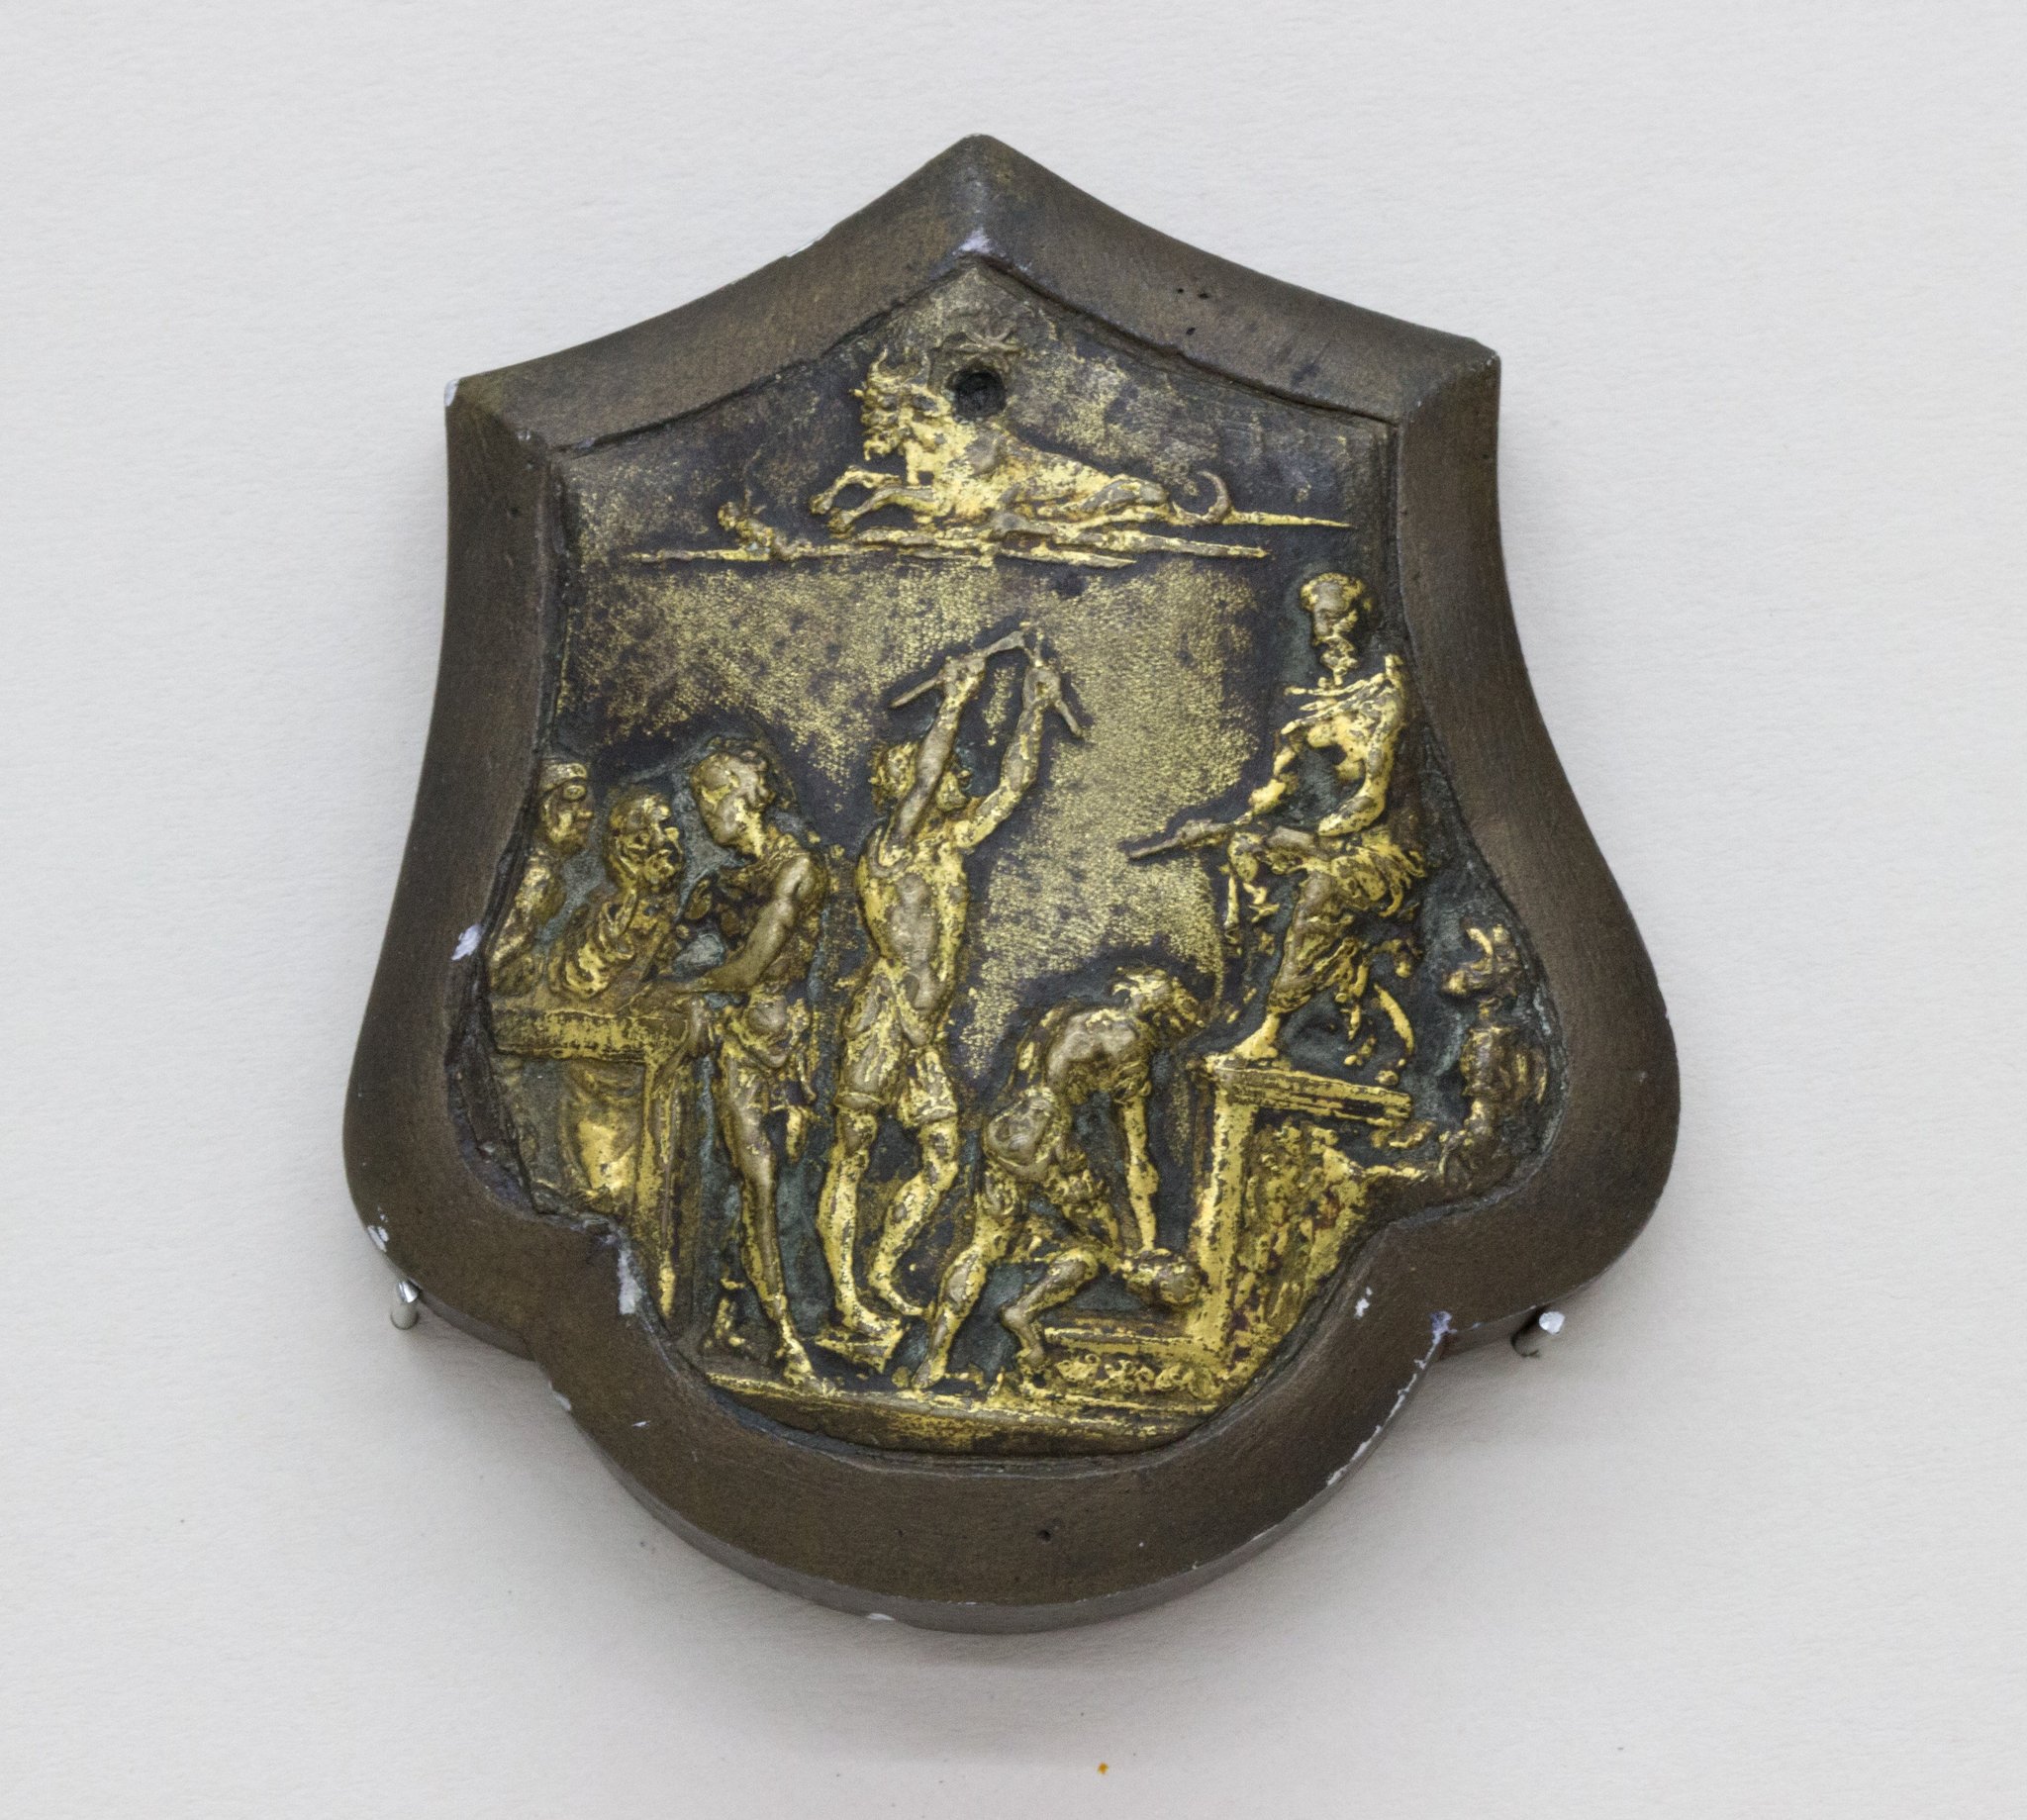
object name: plaque of sword pommel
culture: north italian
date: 1500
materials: bronze, gold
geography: italy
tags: men